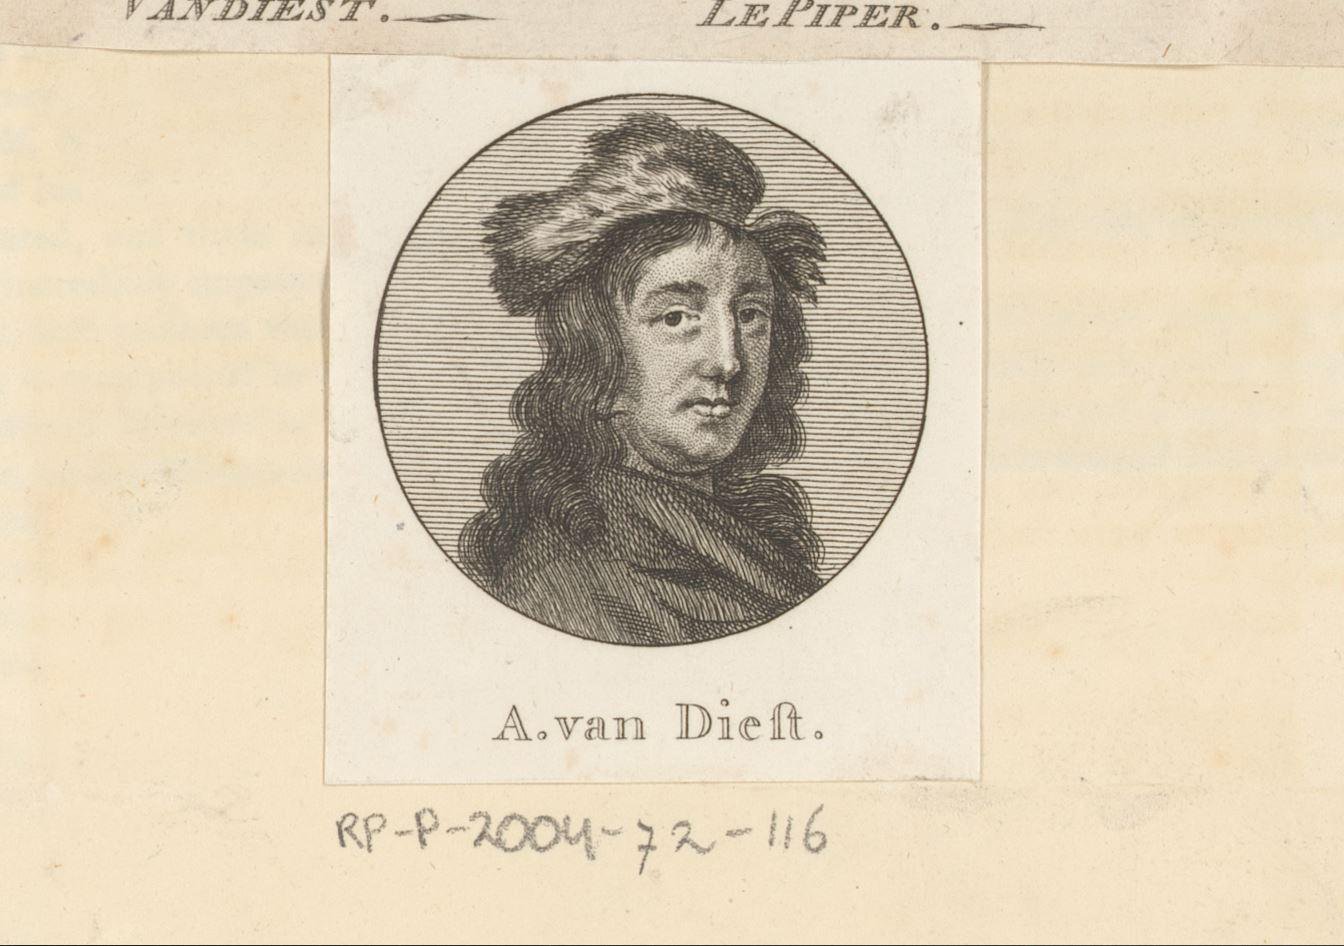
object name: print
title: A. van Diest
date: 1791-1800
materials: paper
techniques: engraving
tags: the hague, london, painter, print maker, adriaen van diest, historical persons, portrait, self-portrait of painter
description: De samensteller heeft deze prent in het album geplakt als illustratie bij: Pilkington, Matthew en Johann Heinrich Füssli. A dictionary of painters, from the revival of the art to the present period. 4 dln. Londen: John Crowder, 1805, dl. 1, p. 156.